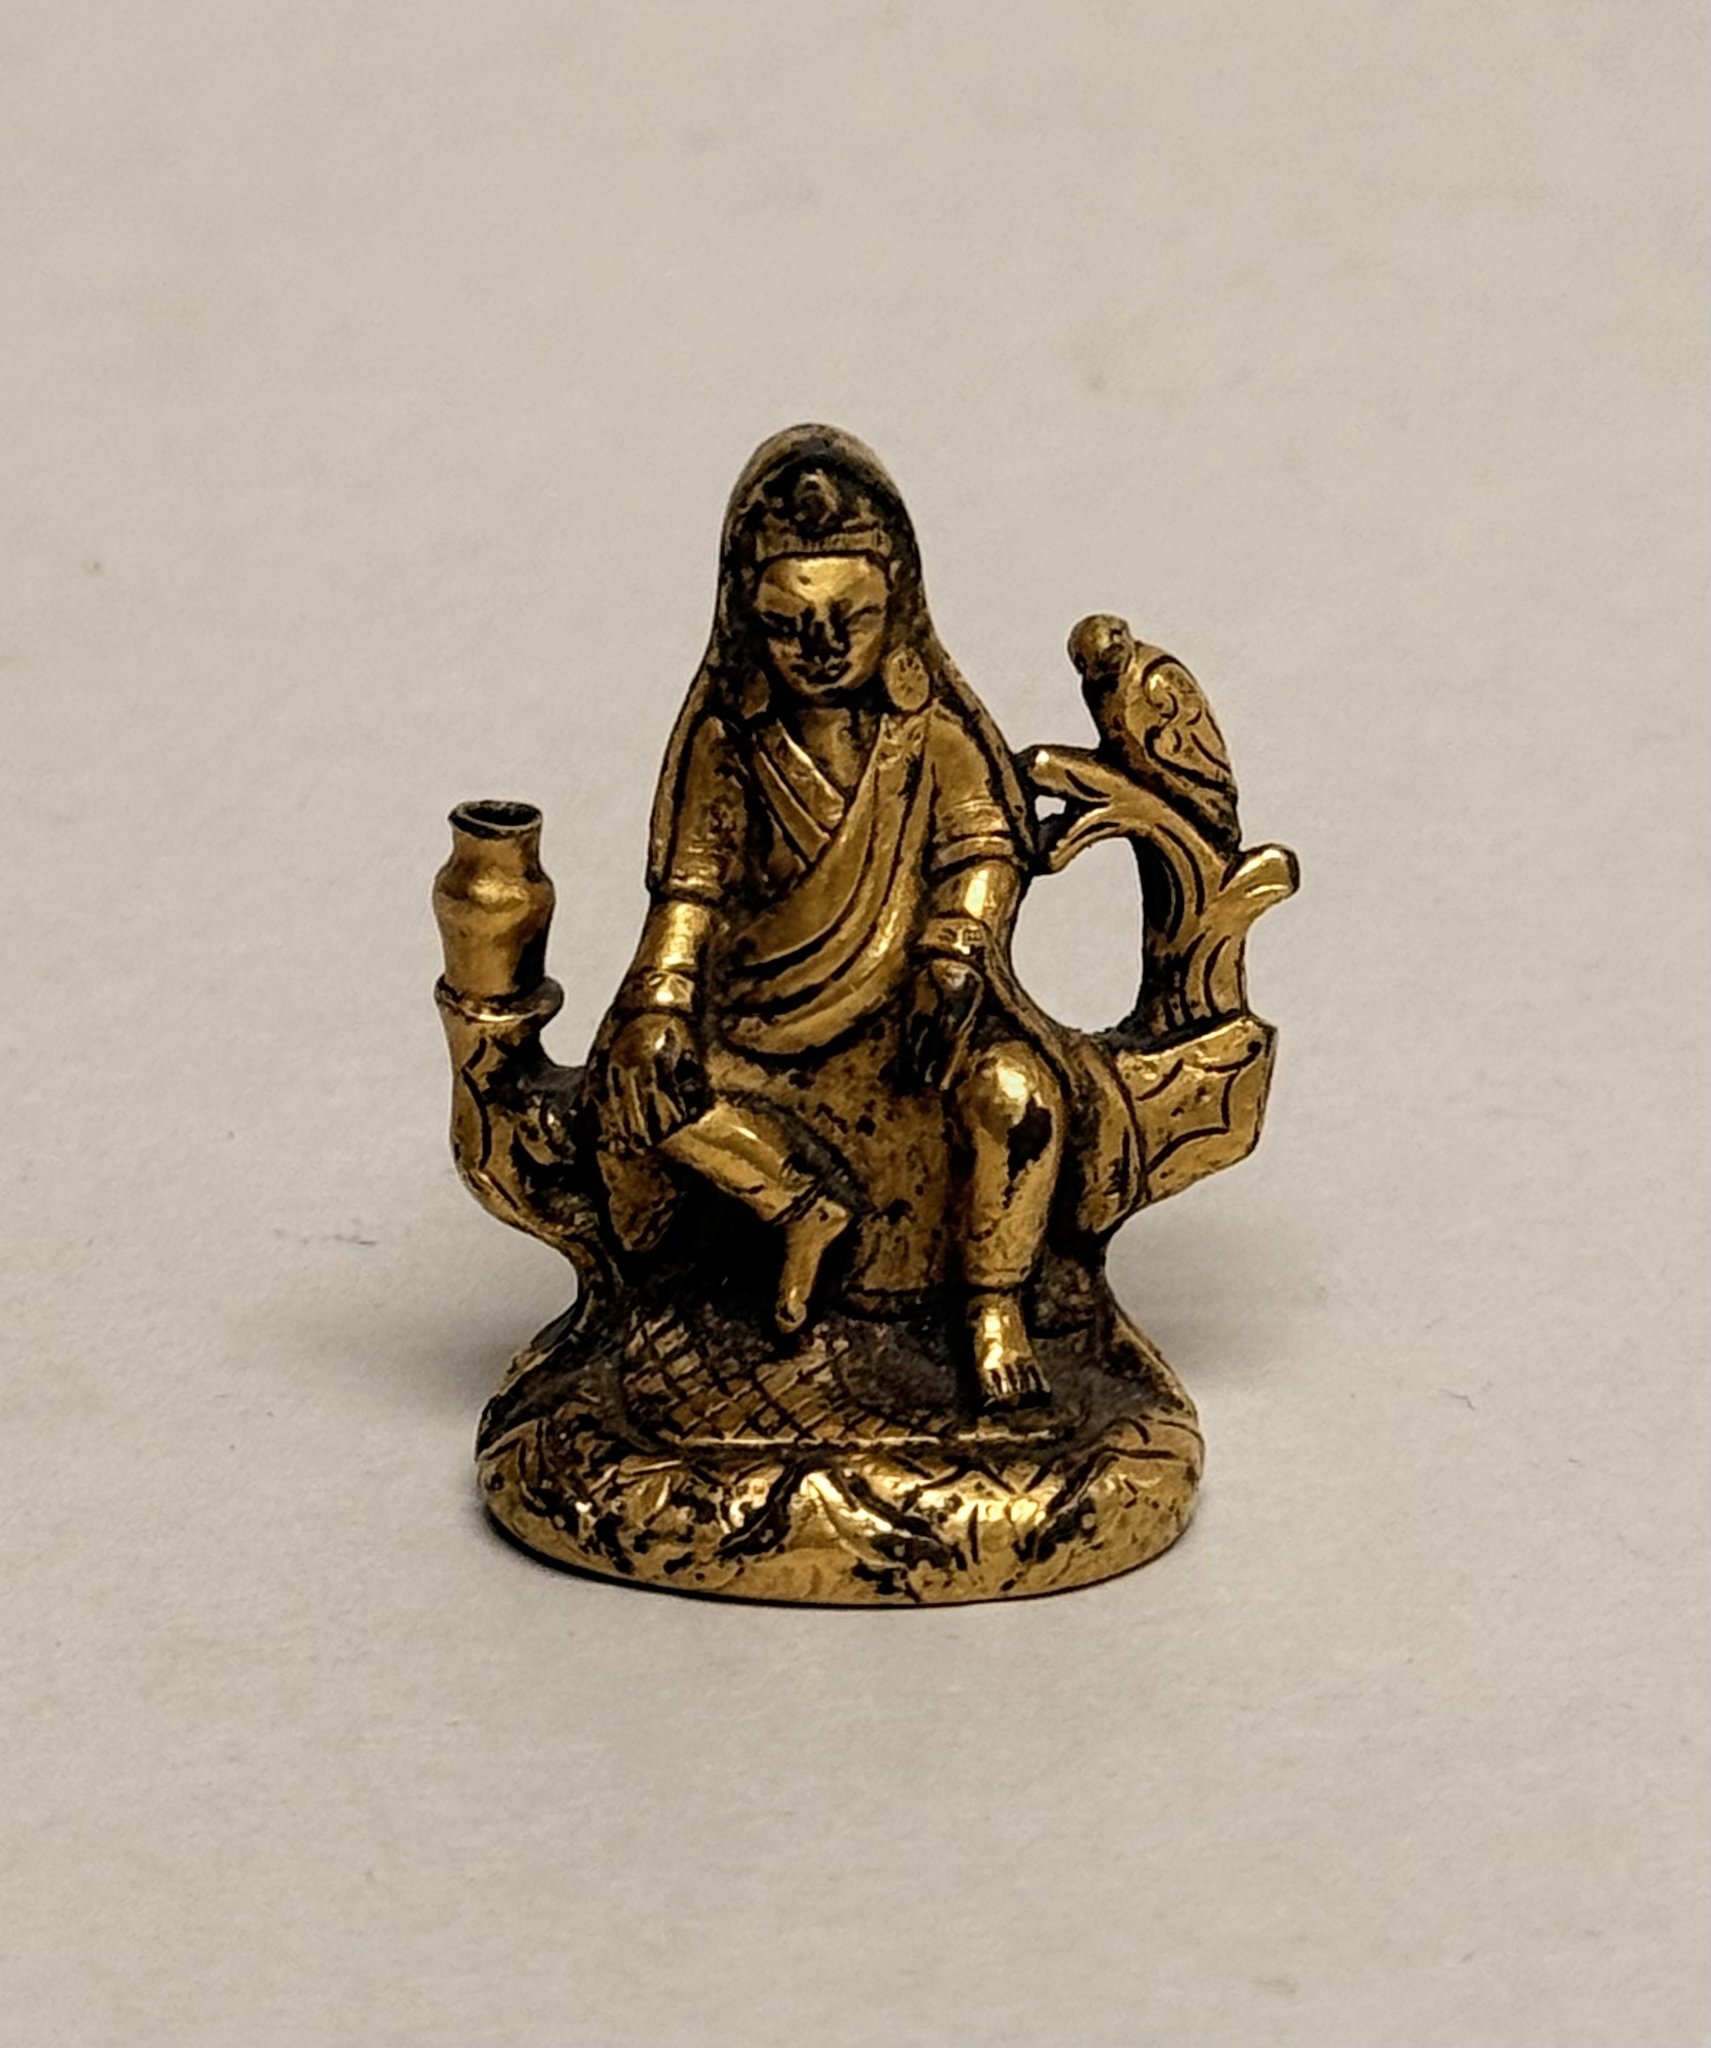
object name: figure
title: Statuette of Guanyin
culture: chinese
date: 1701-1800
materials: gilt bronze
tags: bodhisattvas